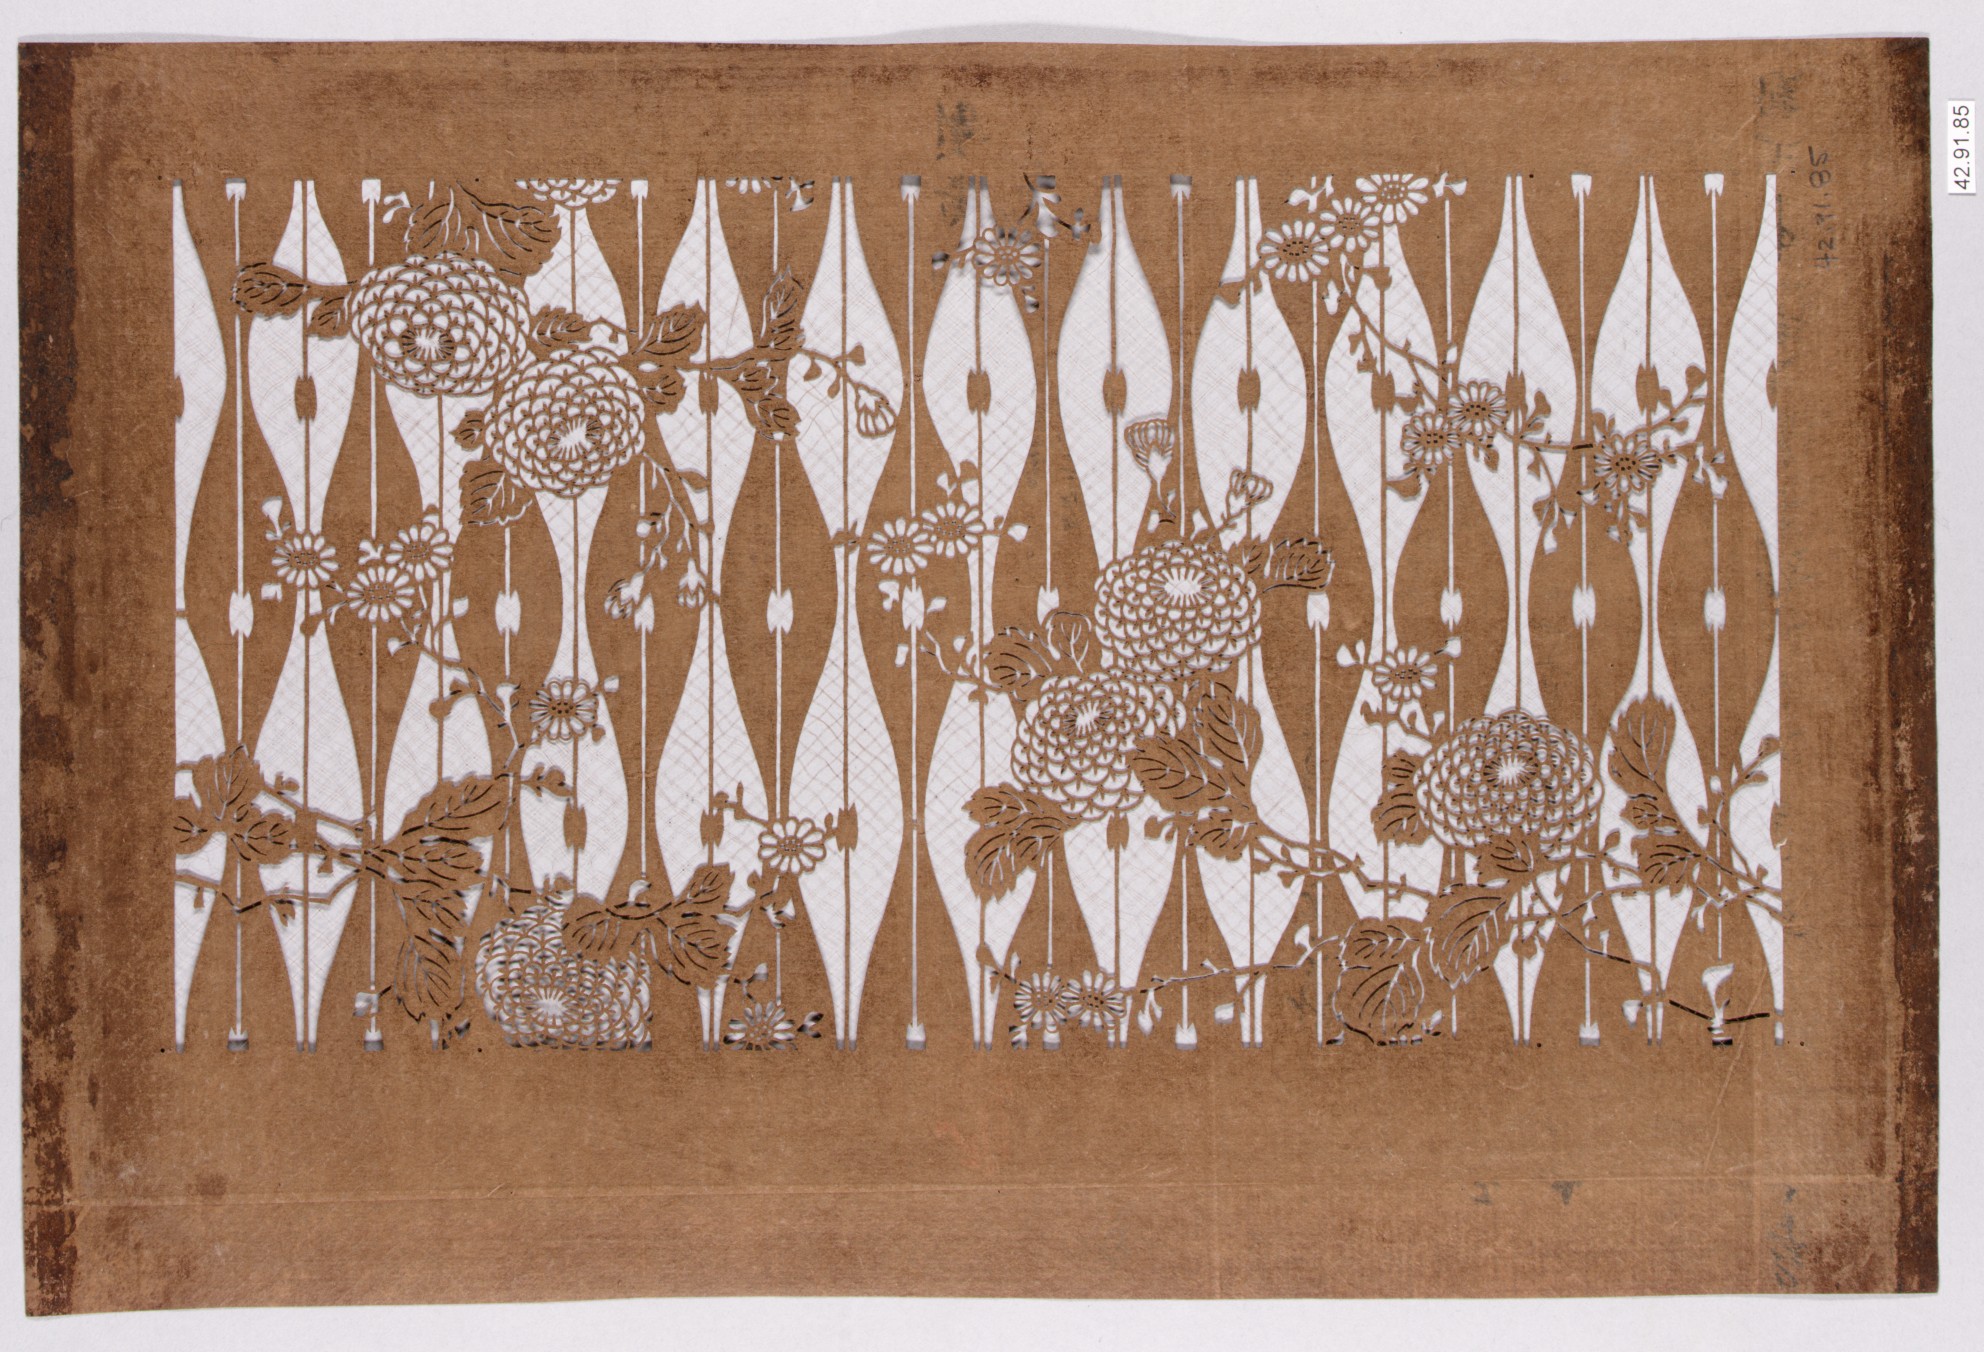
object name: stencil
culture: japanese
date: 1801-1900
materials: paper, silk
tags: flowers